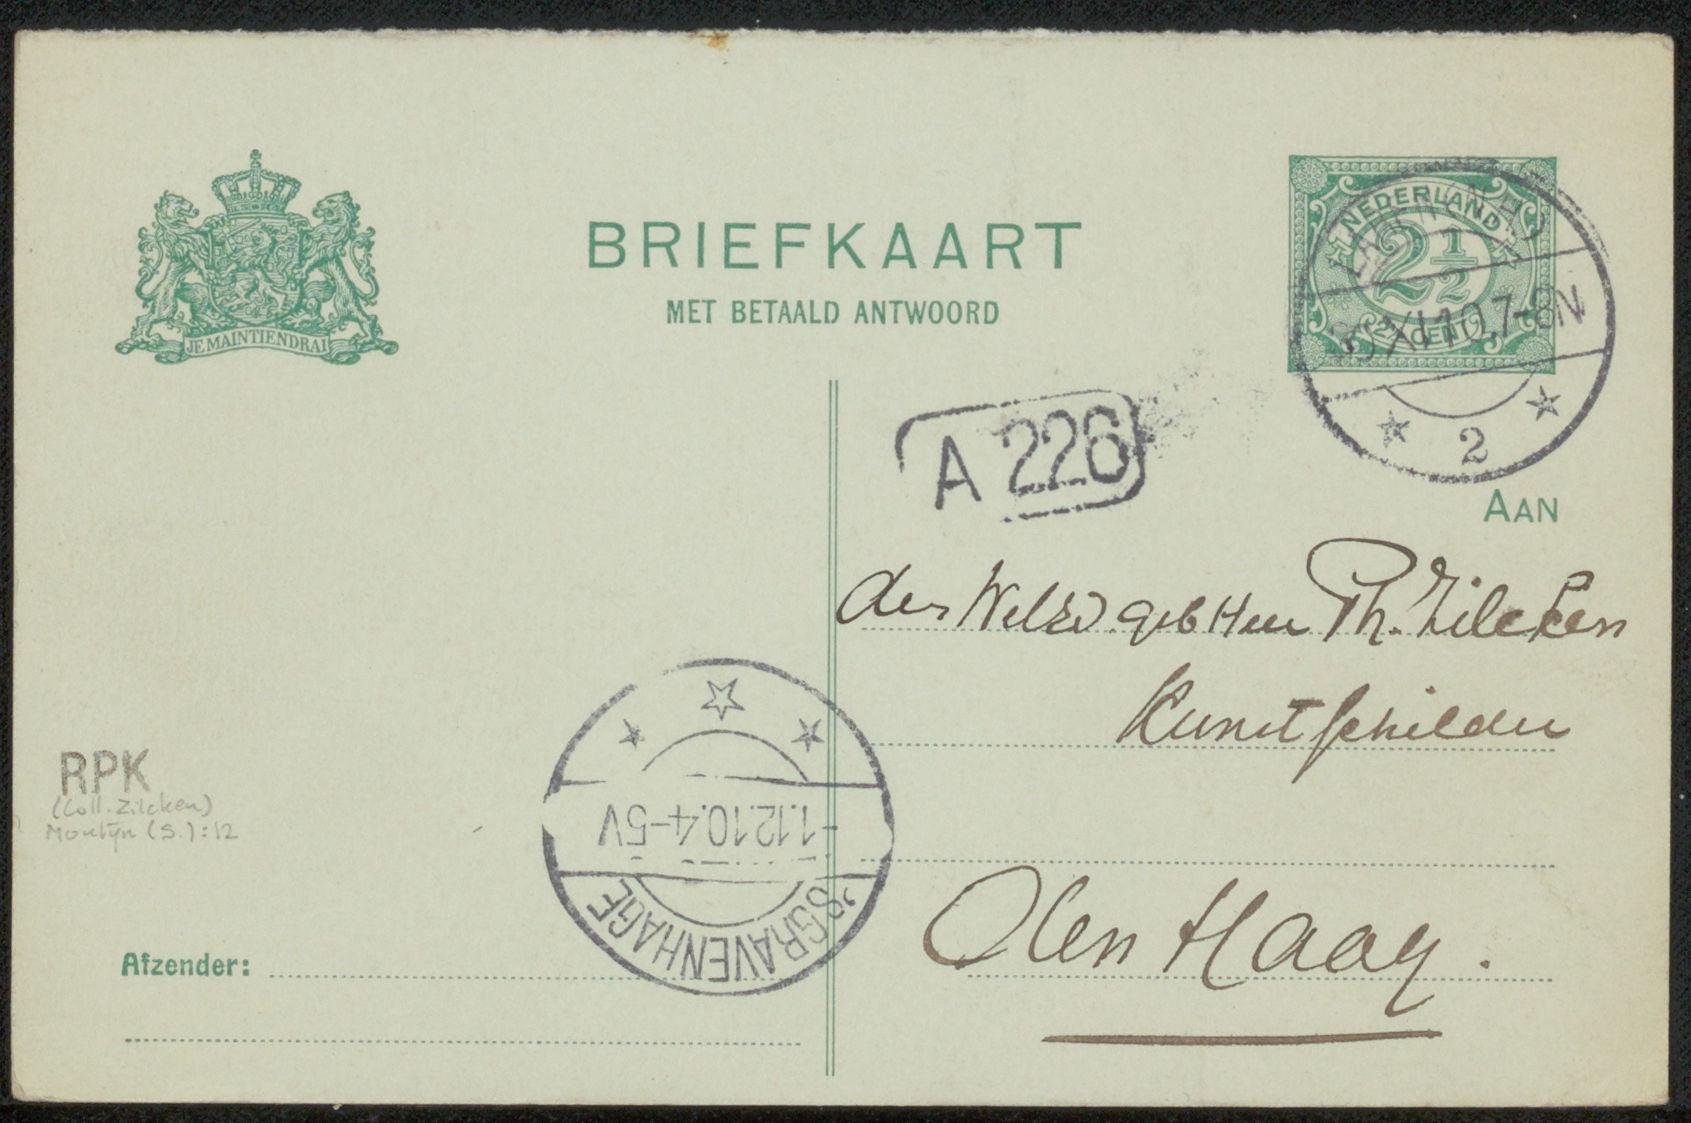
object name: postcard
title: Briefkaart aan Philip Zilcken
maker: simon moulijn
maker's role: draughtsman, print maker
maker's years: 1866-1948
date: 1910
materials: cardboard, ink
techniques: pen, writing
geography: laren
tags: the hague, painter, philip zilcken, exhibition ~ art, rome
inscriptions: collector's mark: ‘RPK’